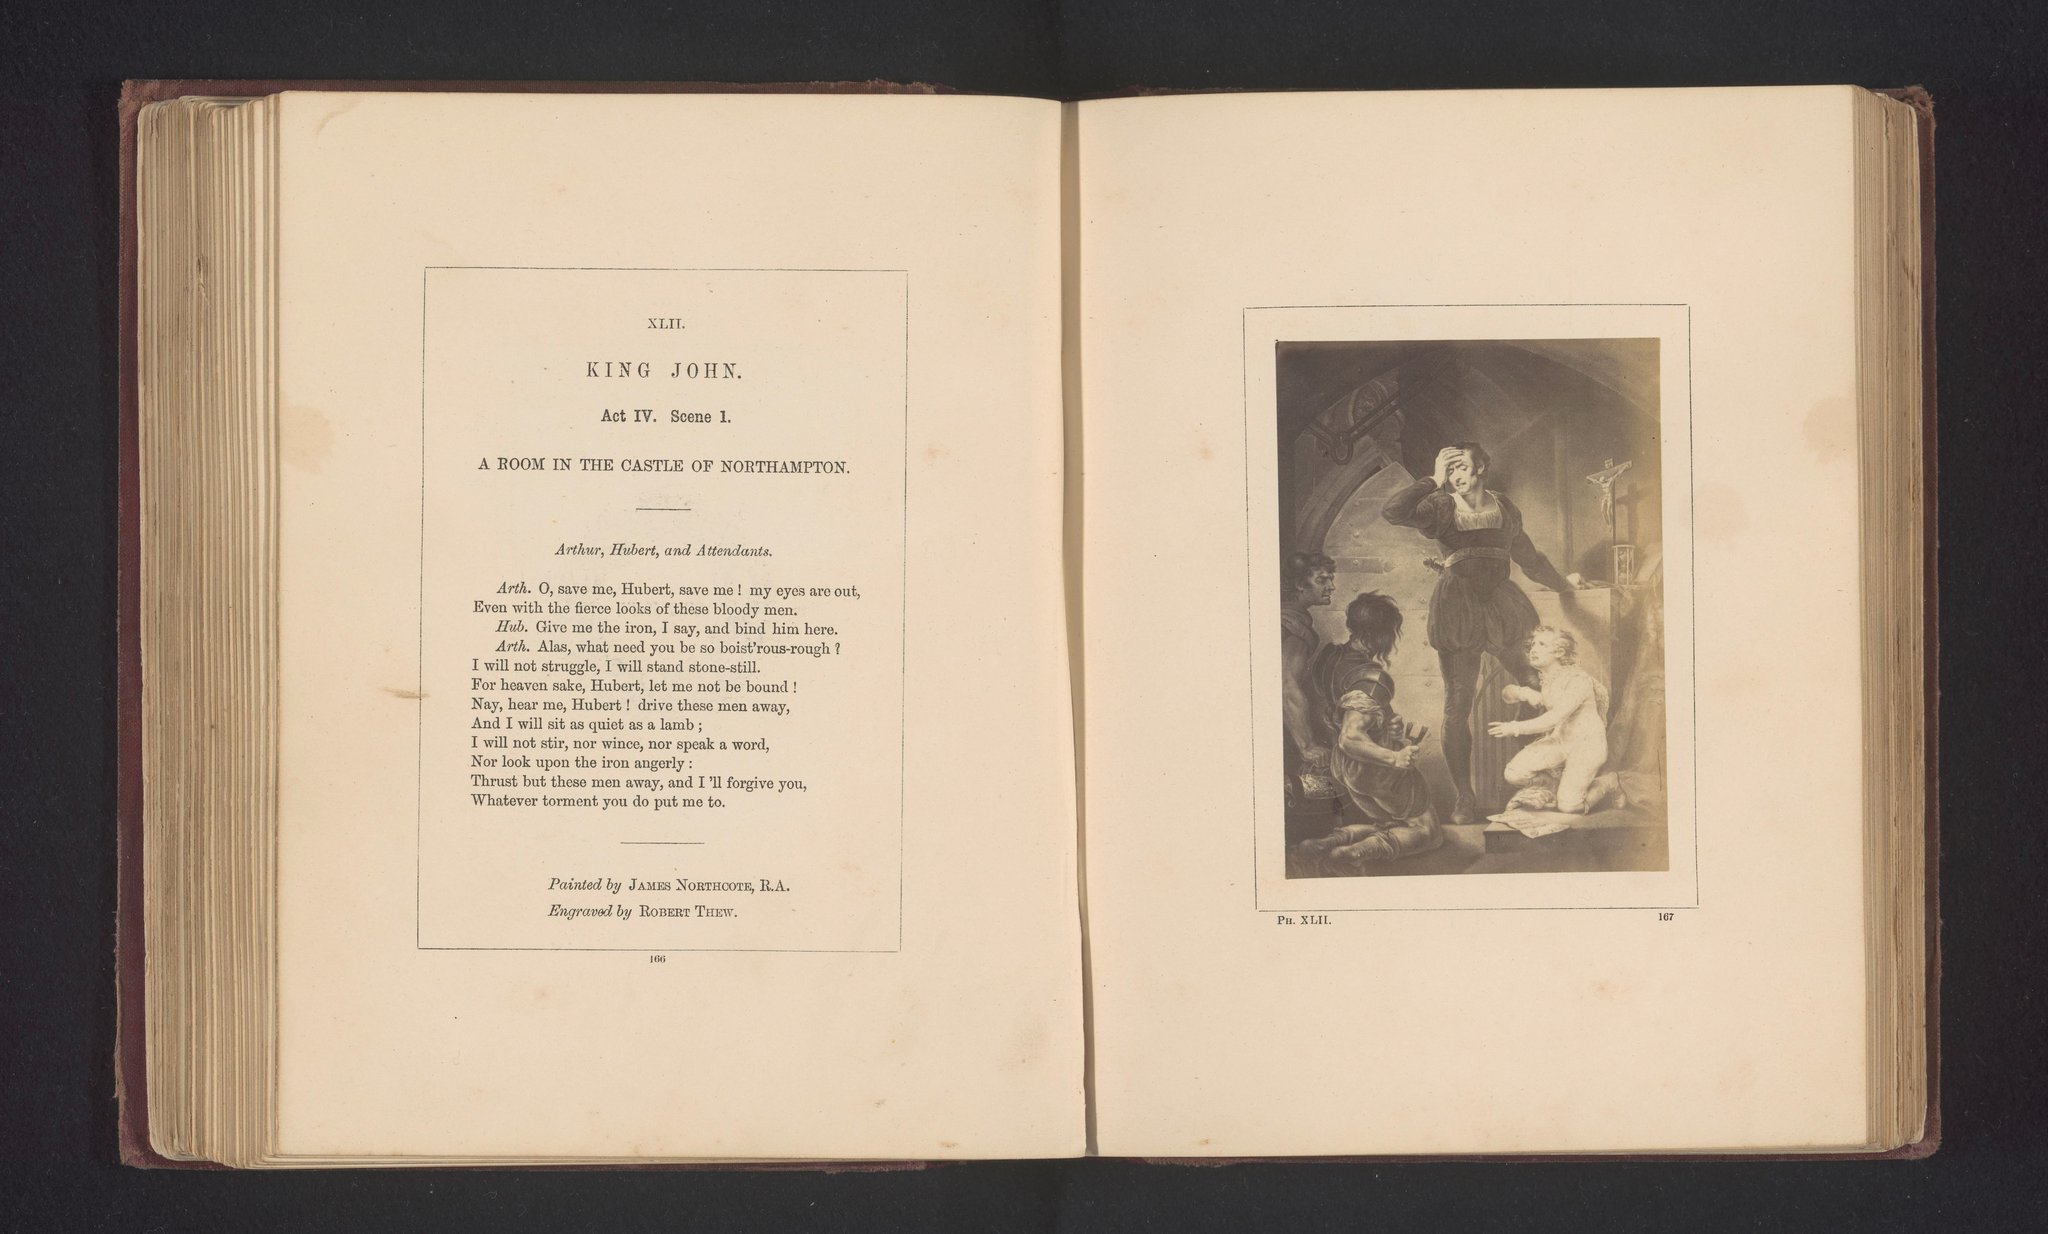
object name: reproduction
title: Fotoreproductie van een prent naar een schilderij door James Northcote, voorstellend een scene uit Koning Jan door William Shakespeare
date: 1854-1867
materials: photographic support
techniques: albumen print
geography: london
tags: specific works of literature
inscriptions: number: ‘Ph. XLII. 167’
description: Te zien is akte IV, scene 1 met Arthur I, de hertog van Bretagne en Hubert de Burgh.